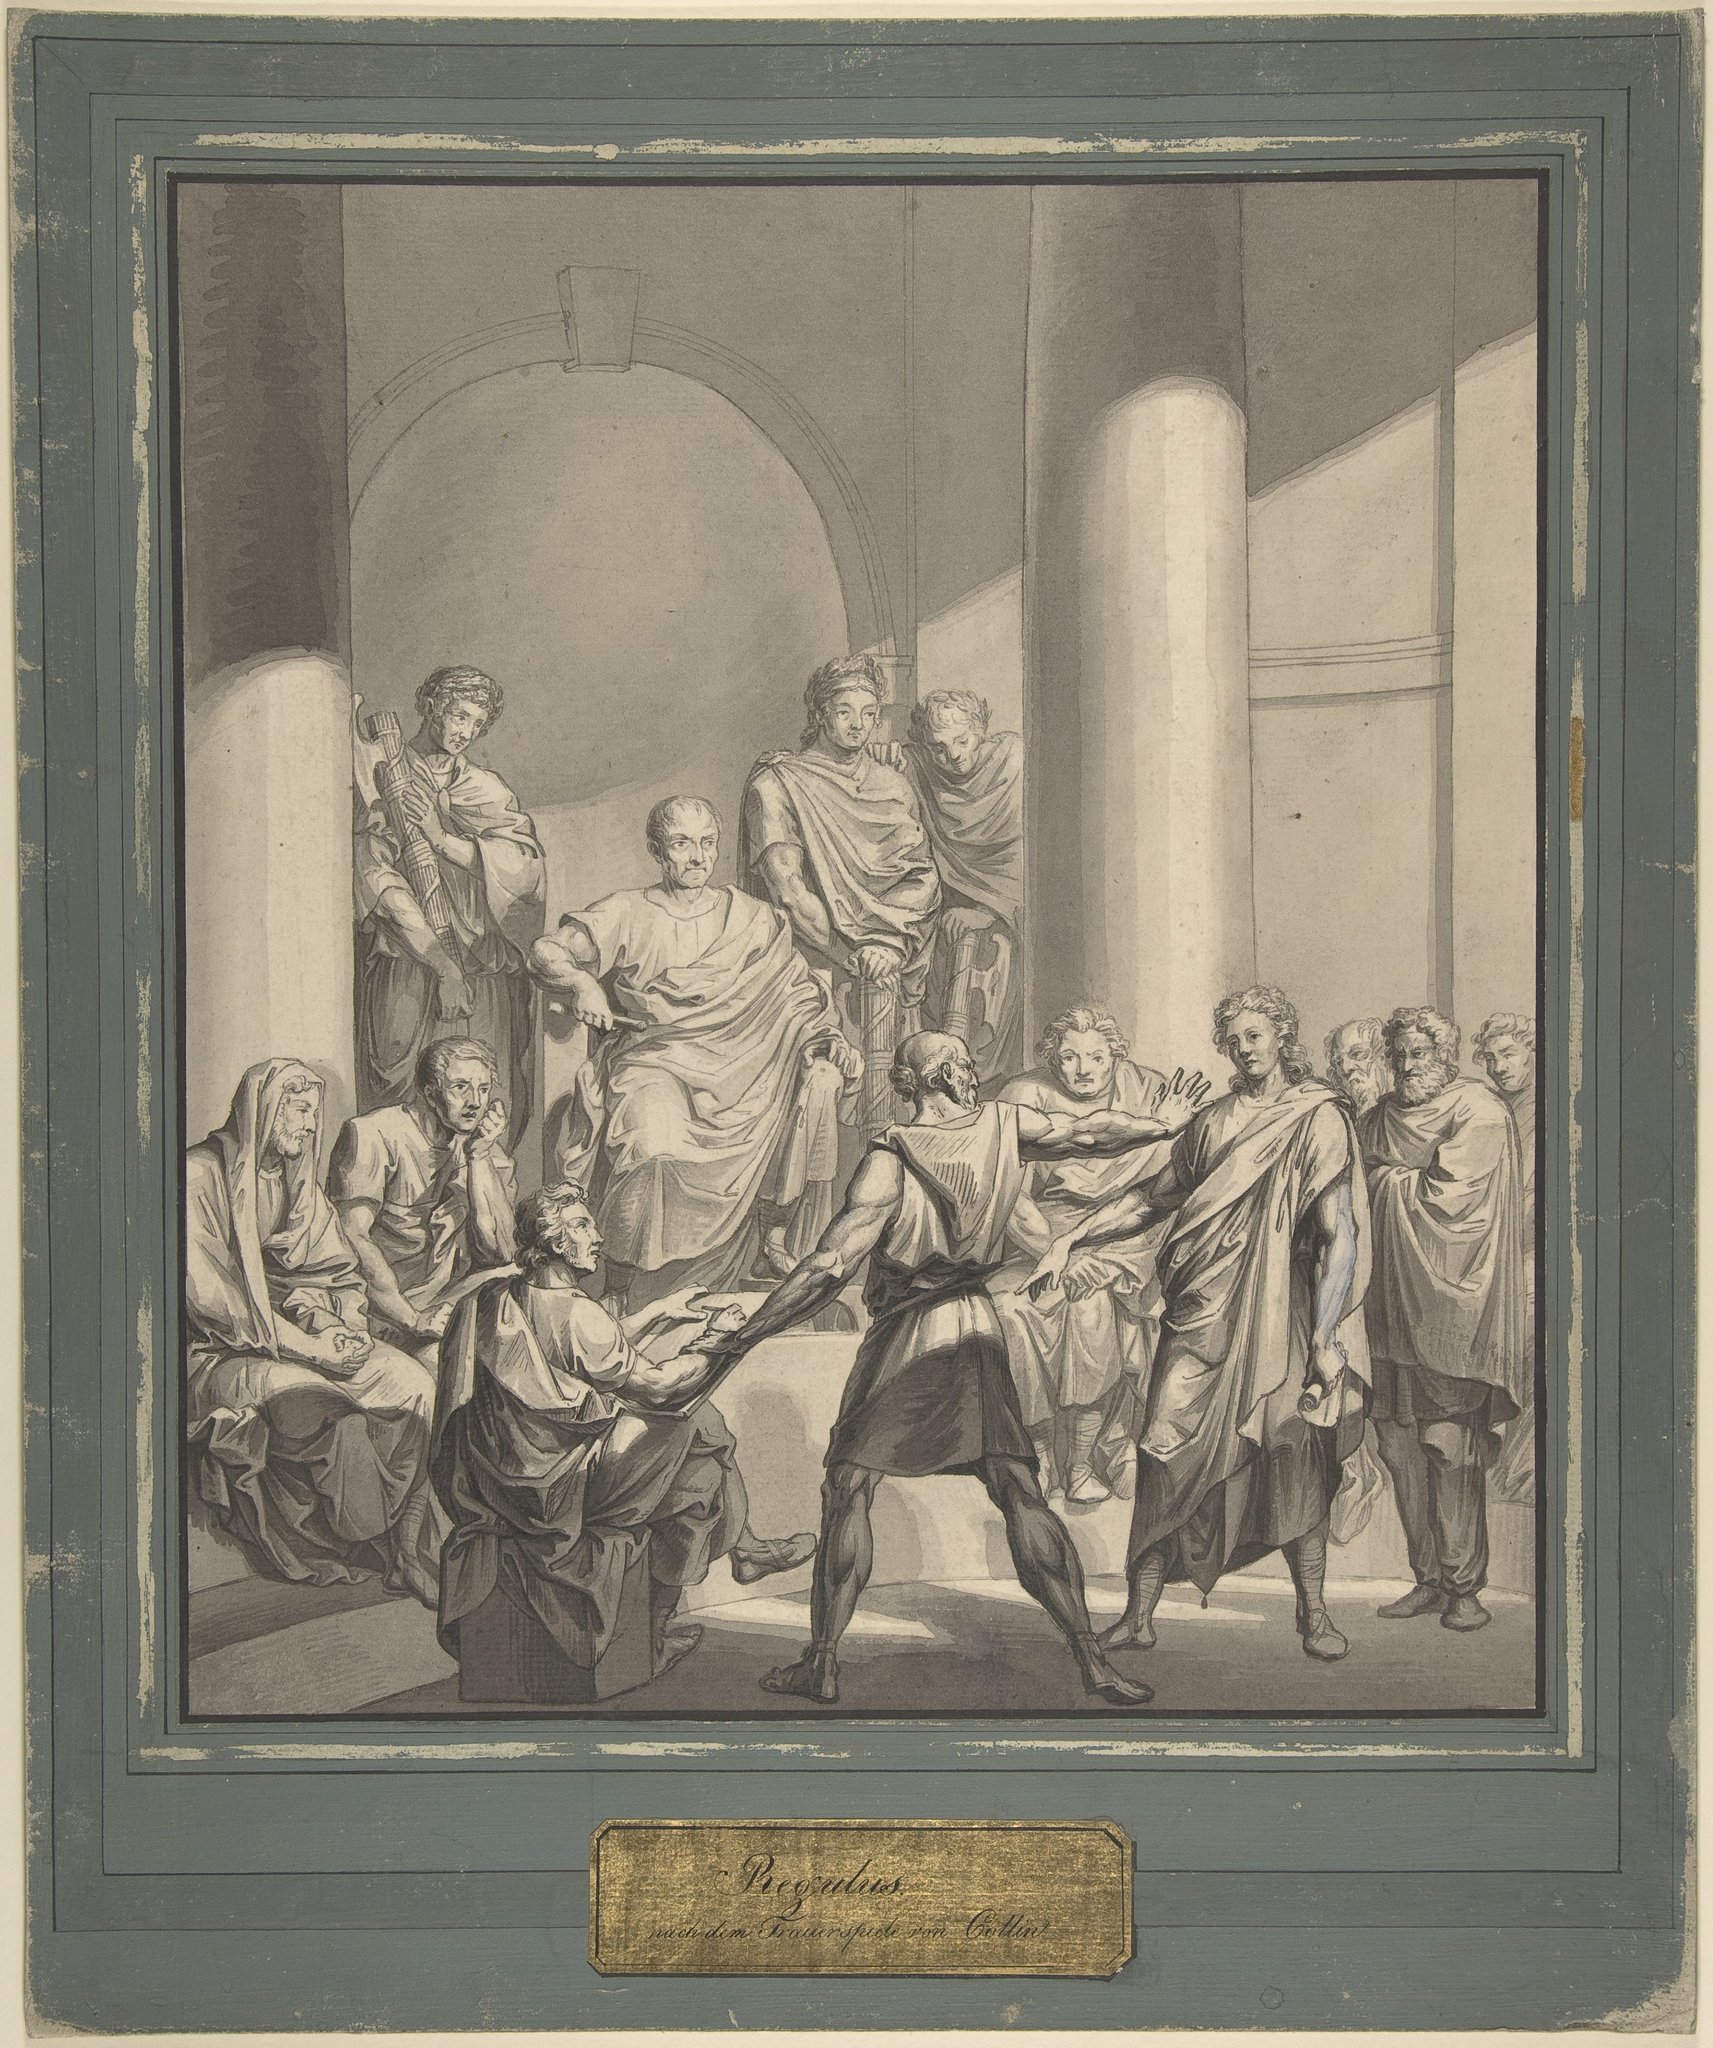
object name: drawing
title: Assembly of Roman Figures, from Regulus, a play by Collin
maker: franz von hauslab the younger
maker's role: artist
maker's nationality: austrian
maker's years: 1798-1883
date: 1801-1900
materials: gouache, graphite, ink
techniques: brush, pen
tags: theatre,men